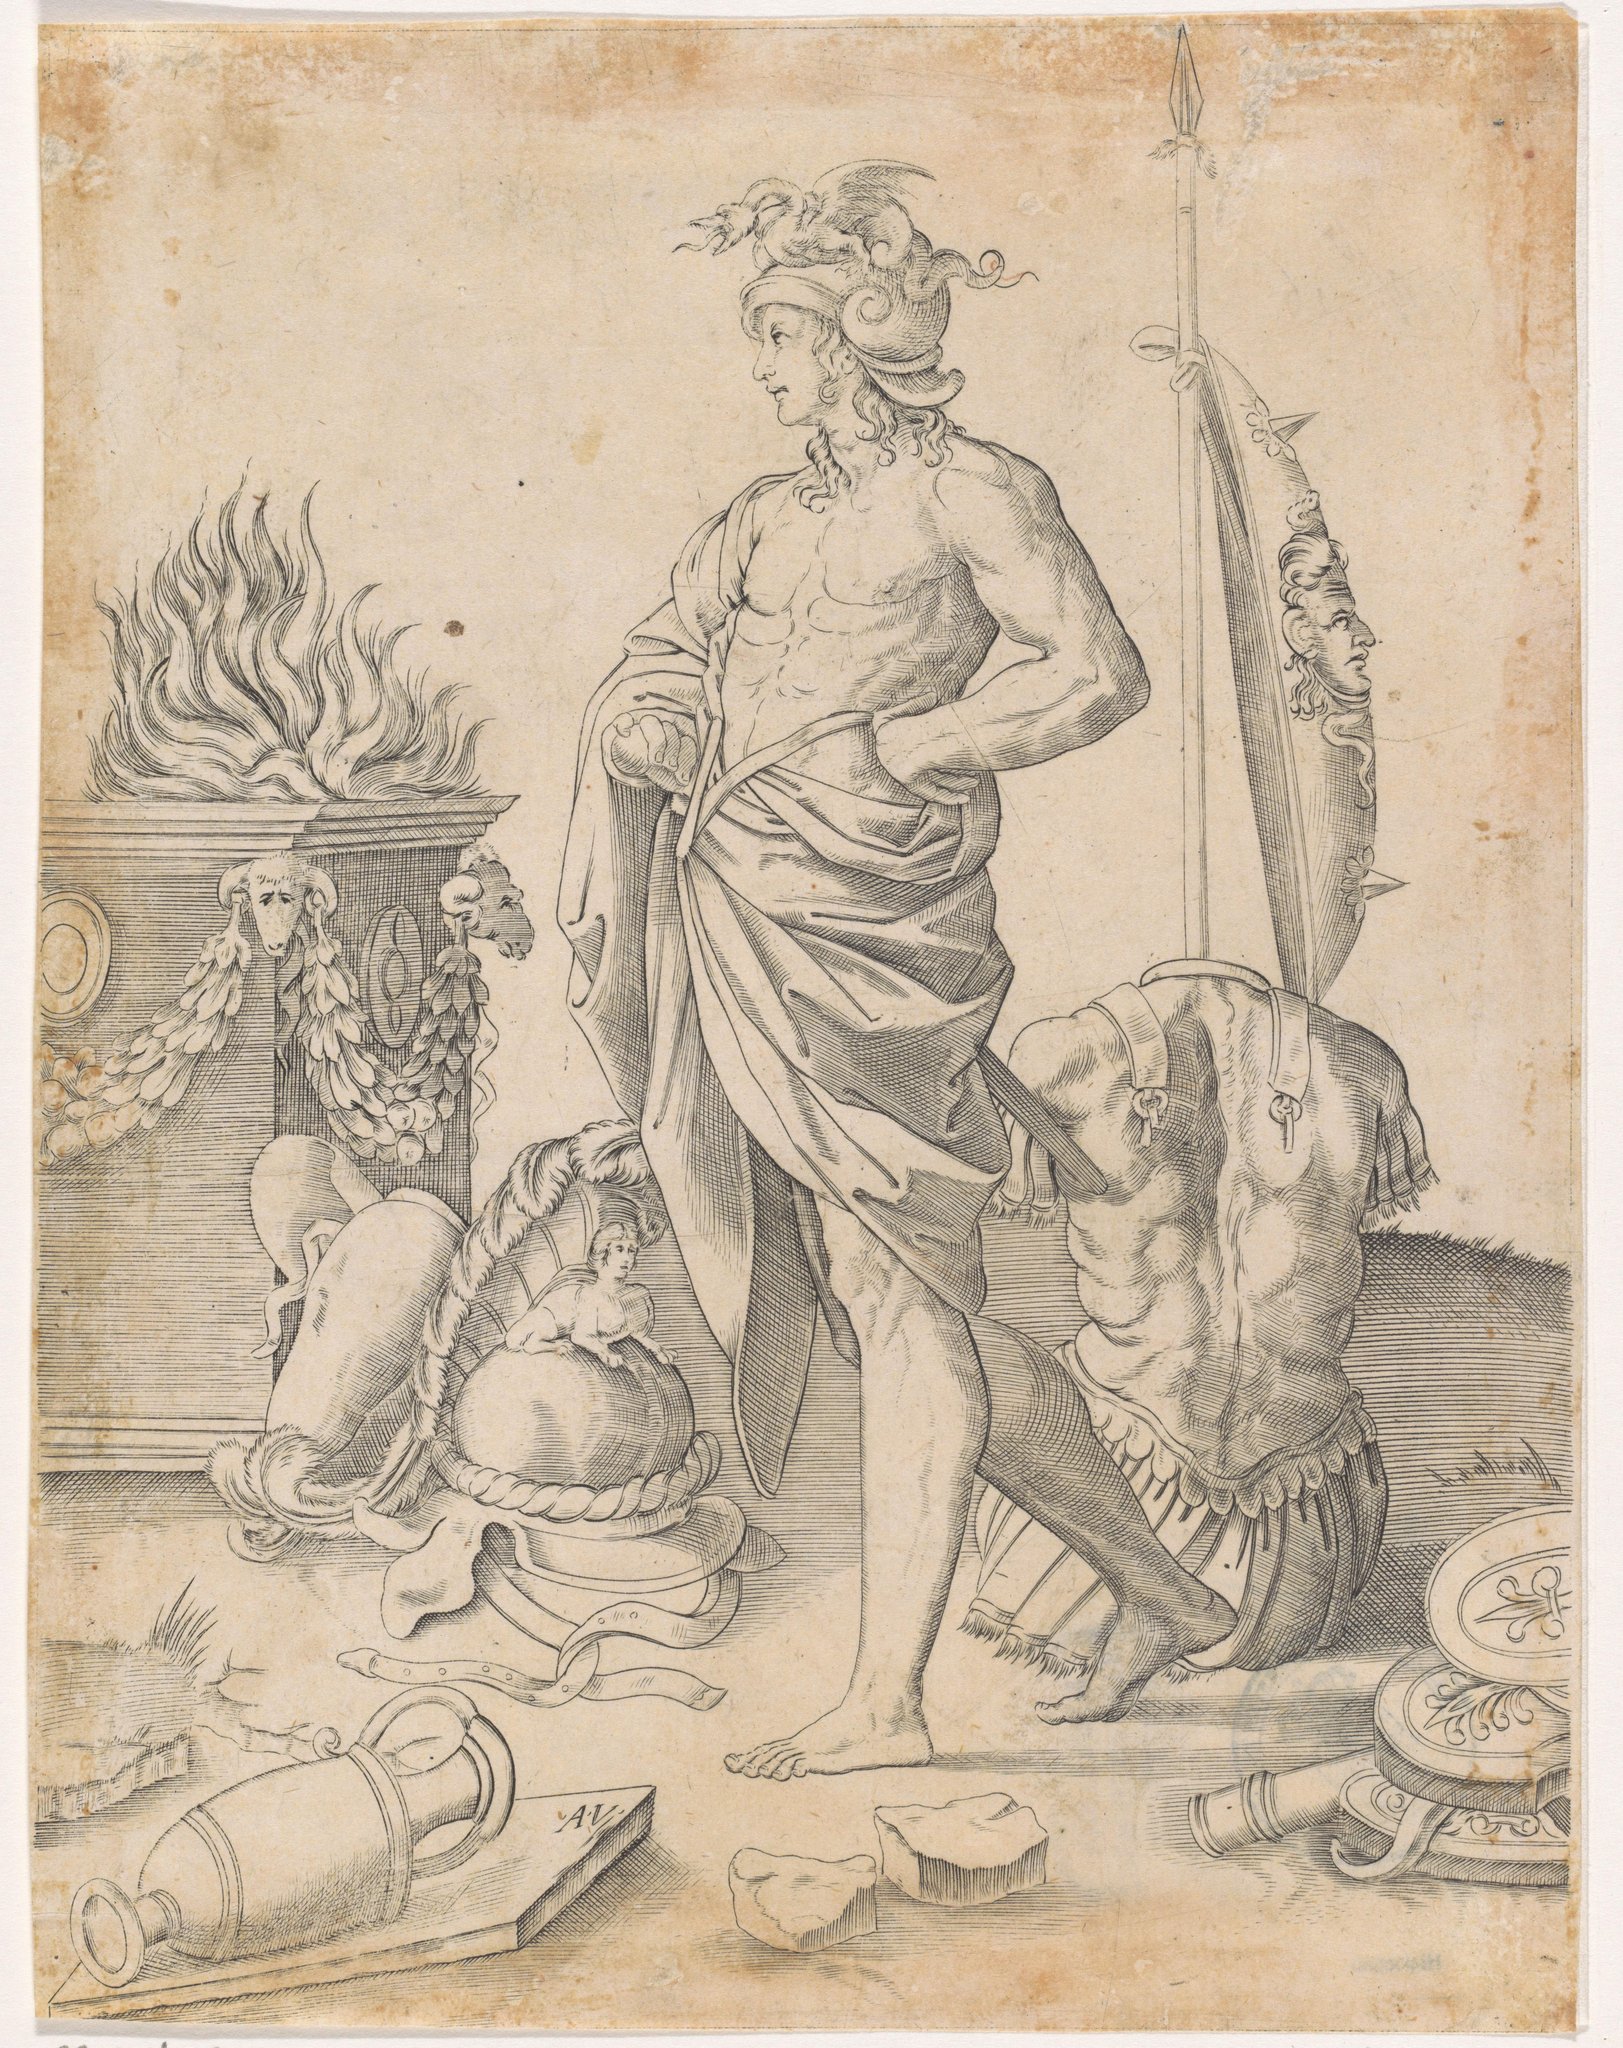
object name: print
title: Jonge held bij een altaar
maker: agostino veneziano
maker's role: draughtsman, painter, print maker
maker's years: 1490-1536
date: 1500-1536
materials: paper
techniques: engraving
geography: italy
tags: armour, altar ~ roman religion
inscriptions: collector's mark: Lugt 10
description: Een jongeman met helm op het hoofd staat bij een altaar. Op de grond liggen onderdelen van een wapenrusting en een omgevallen kruik.